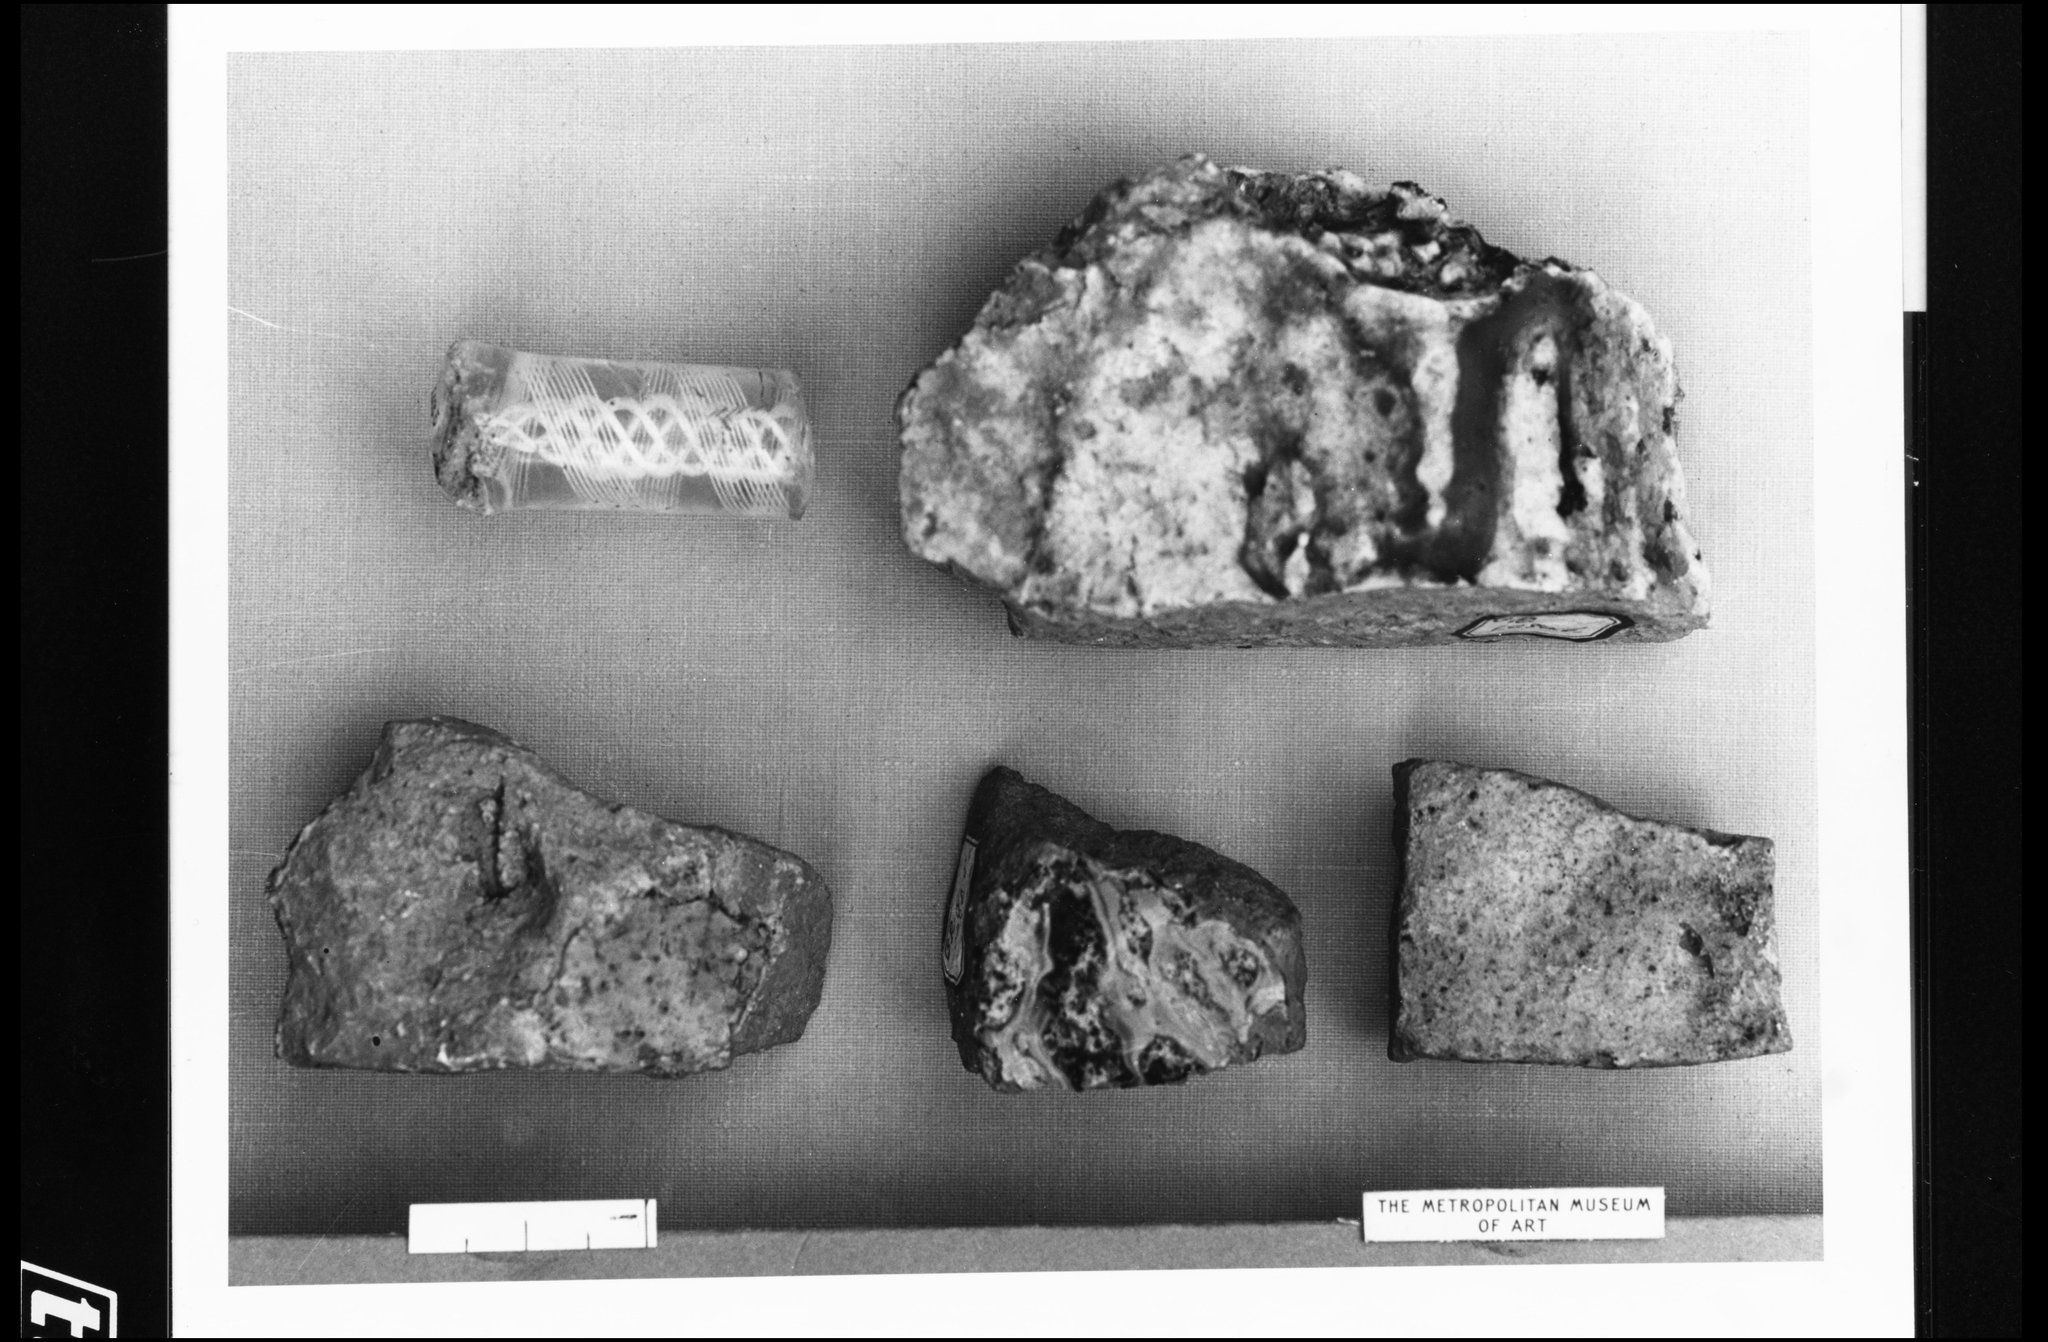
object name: fragment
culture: american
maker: stiegel's manheim factory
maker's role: maker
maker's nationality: american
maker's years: 1763-1774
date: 1763-1774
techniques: glassblowing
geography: united states